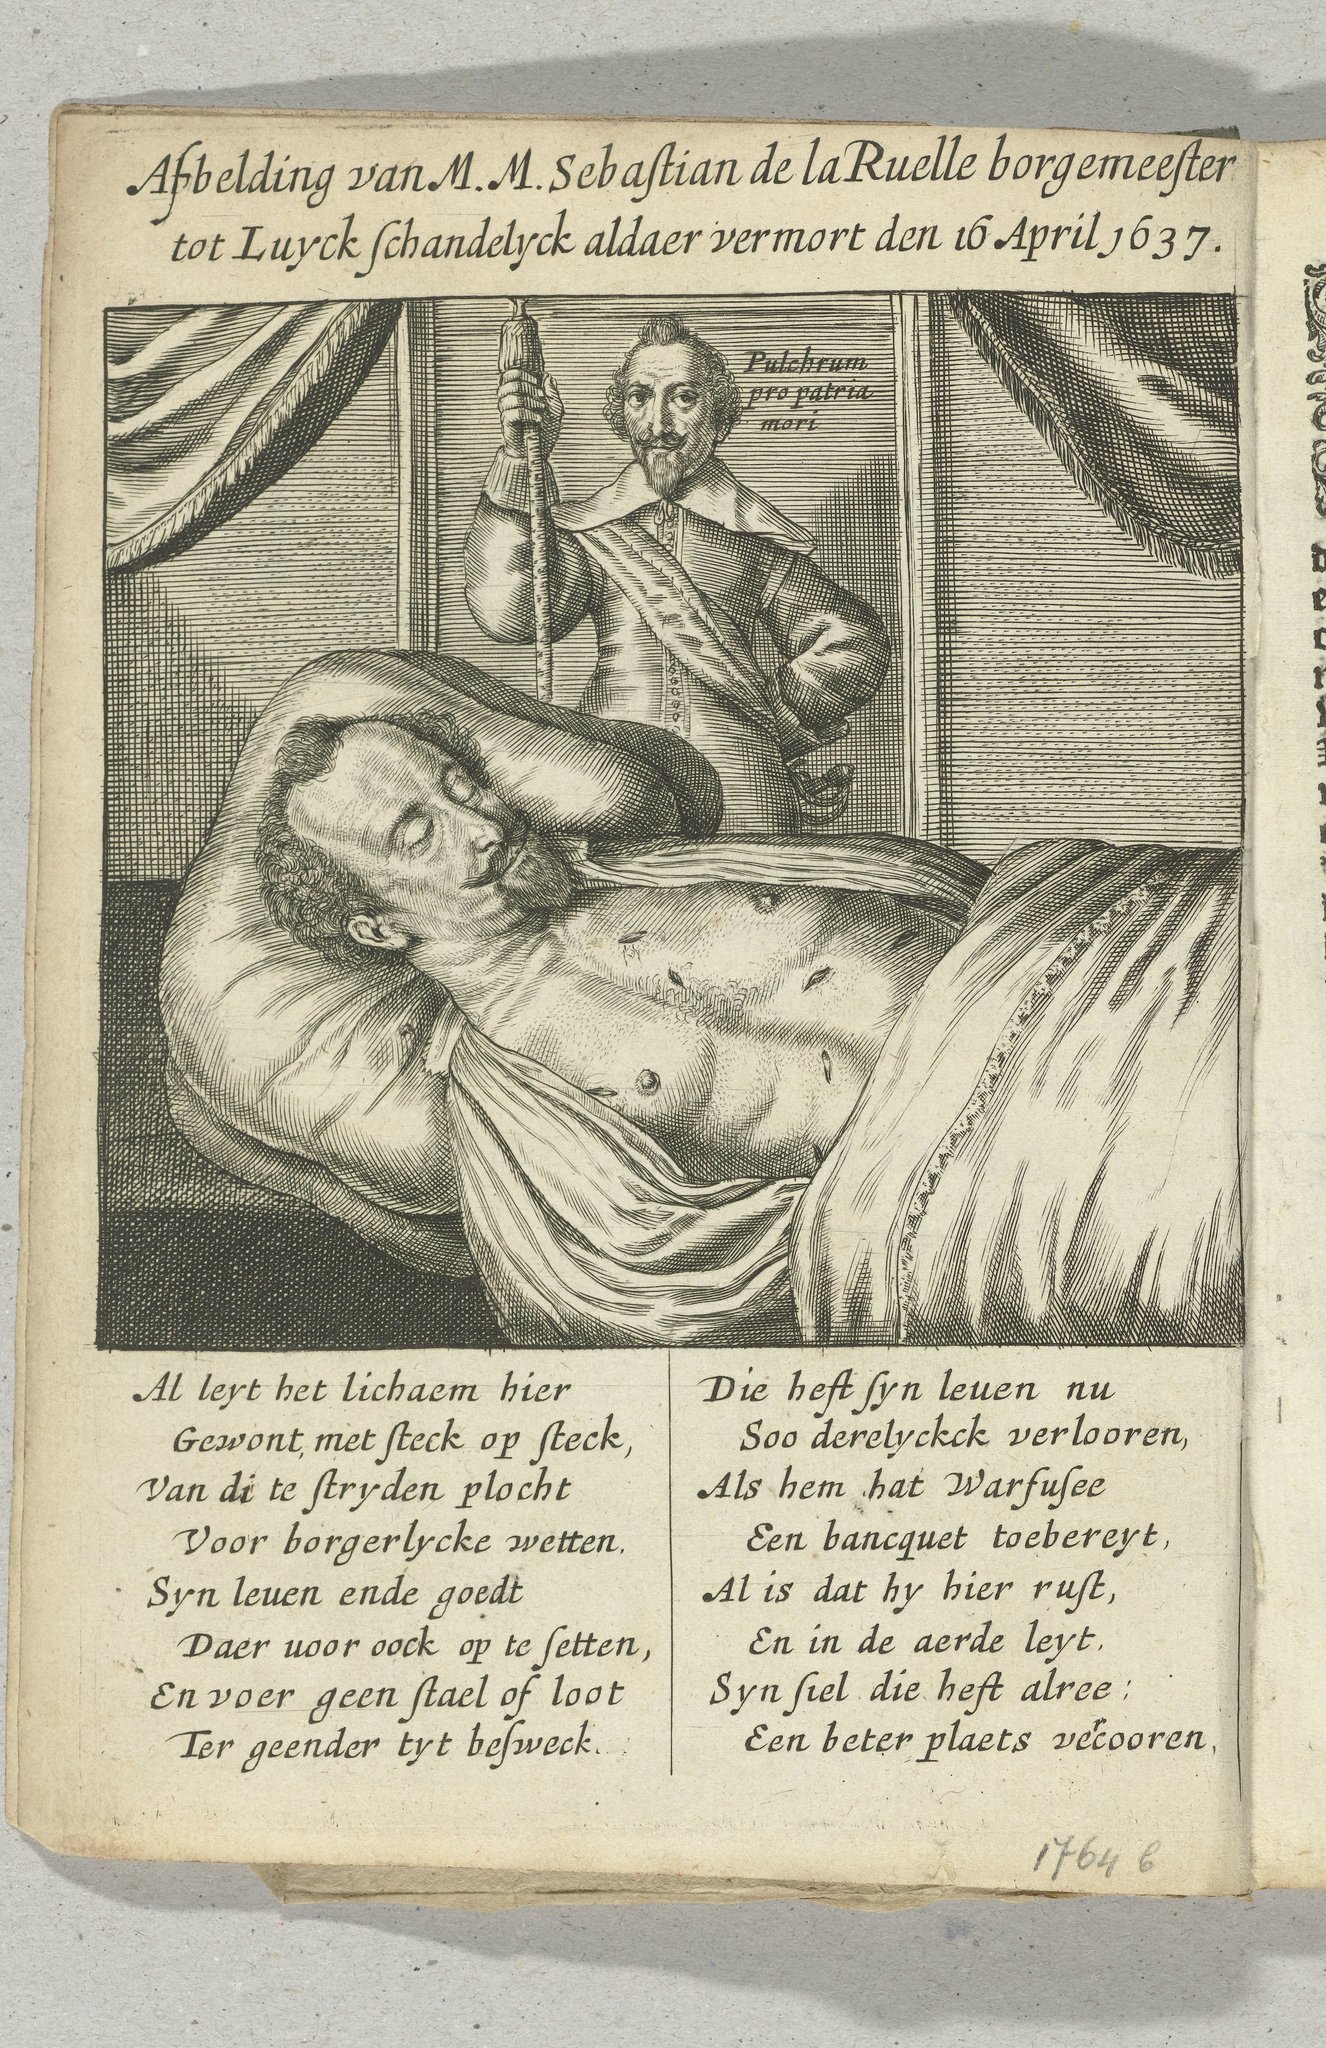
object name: print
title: Afbelding van M.M. Sebastian de la Ruelle borgemeester tot Luyck schandelyck aldaer vermort den 16 April 1637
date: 1637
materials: paper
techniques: engraving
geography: northern netherlands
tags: liège, politician, the corpse, lying in state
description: Het lijk van de vermoorde Sebastiaen de la Ruelle, burgemeester van Luik, door Reinier van Renes, graaf de Warfusé, die de stad van Frankrijk onder Spaans bestuur wilde brengen, 16 april 1637. Het lichaam van de burgemeester liggend in een bed, de borst met de steekwonden ontbloot. Op de achtergrond een schilderij met een portret van de overledene. In het onderschrift een vers van 16 regels in het Nederlands.